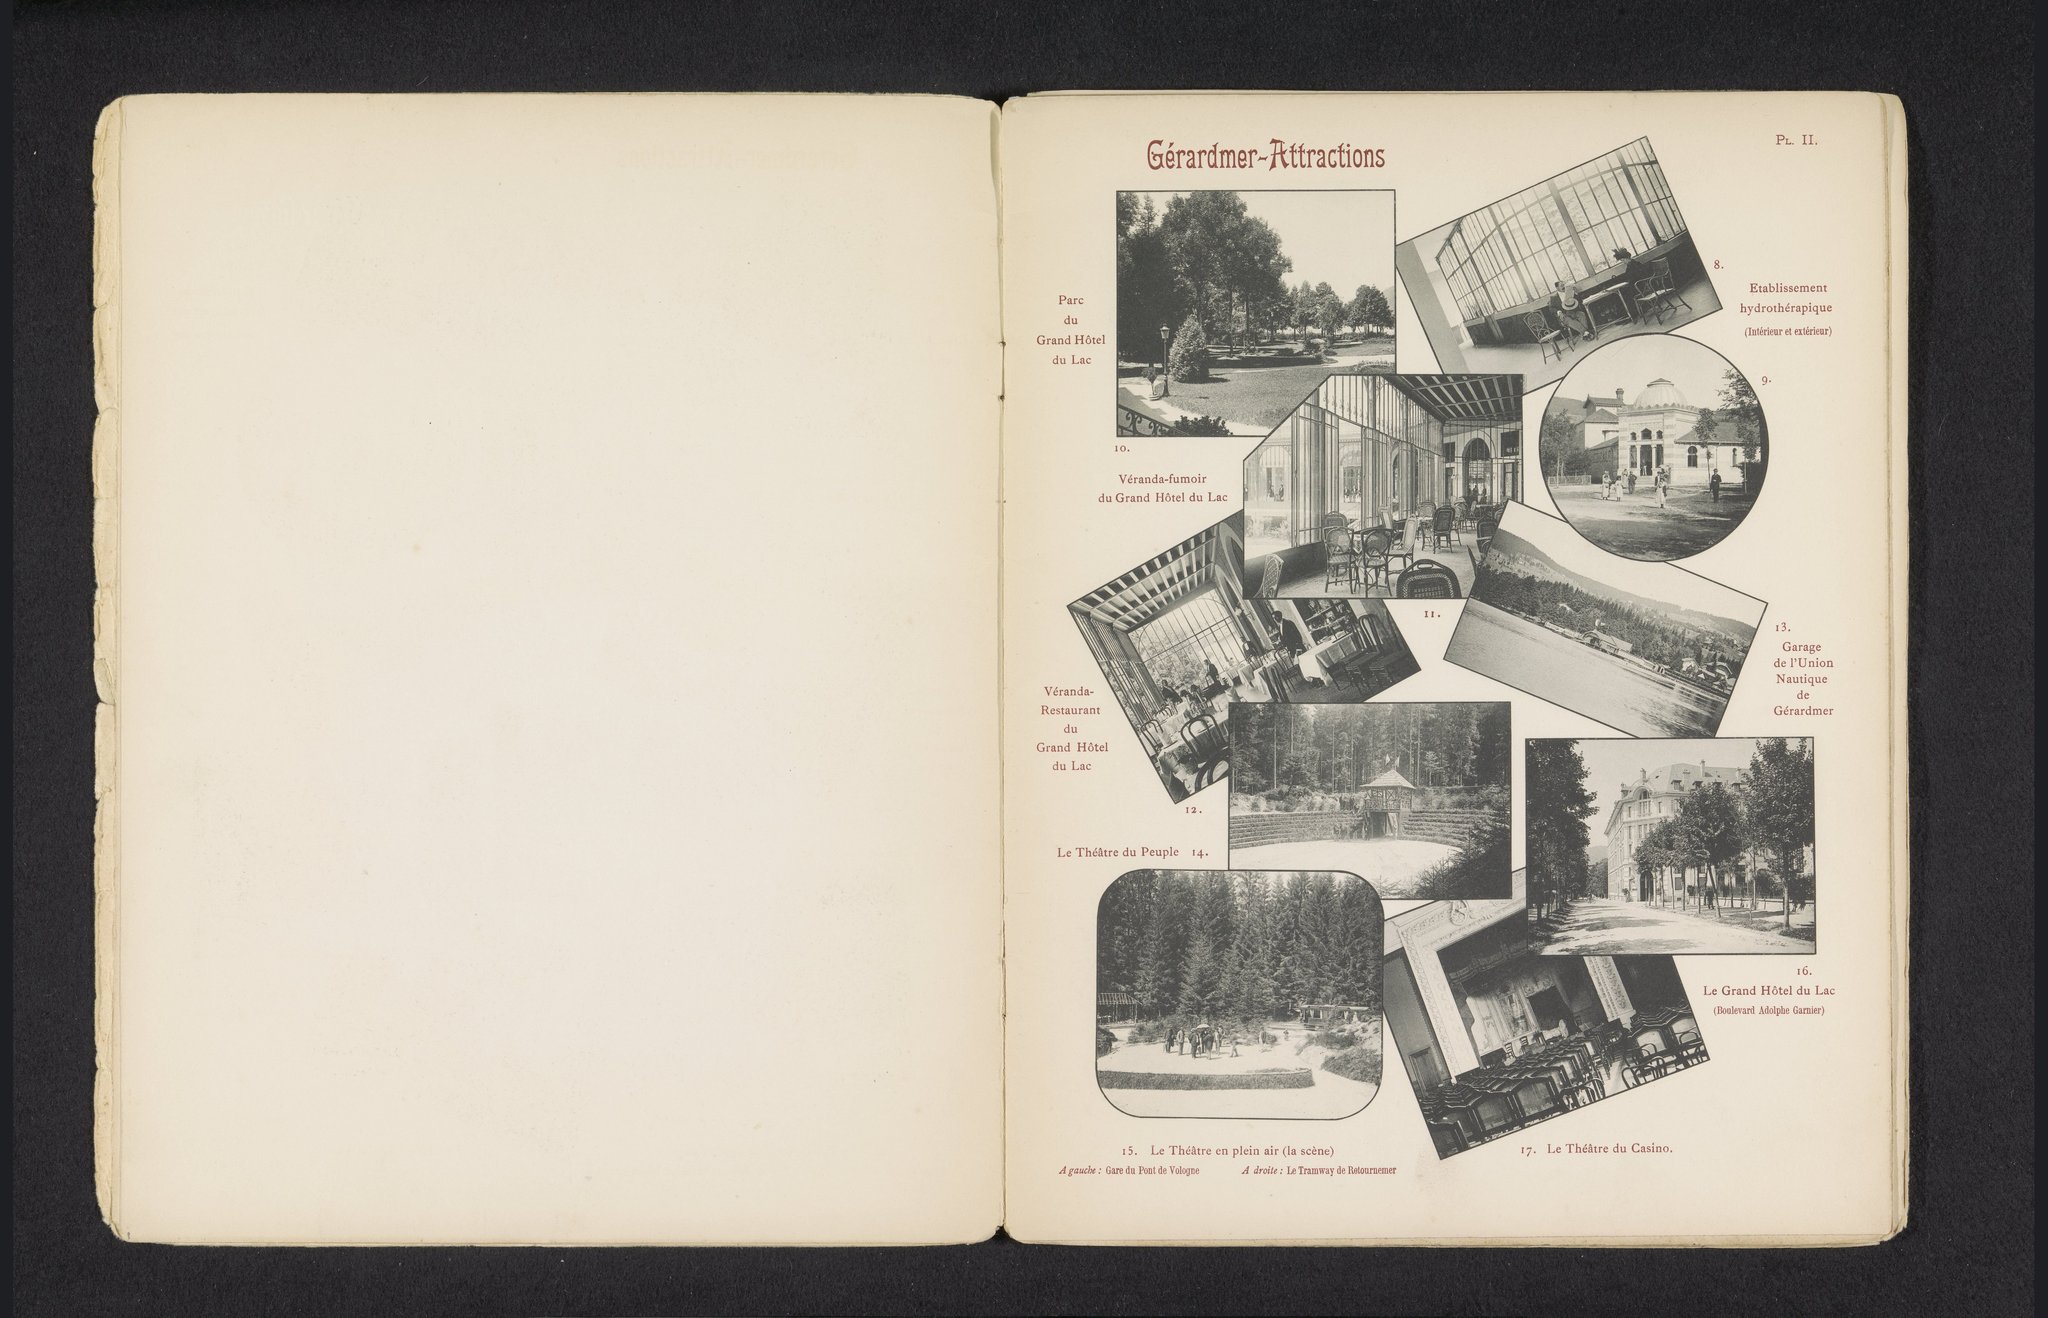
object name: photomechanical print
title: Tien bezienswaardigheden in Gérardmer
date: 1888-1898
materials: paper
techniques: photograph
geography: gérardmer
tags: avenue, boulevard in village, casino, hotel, hostelry, inn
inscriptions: number: ‘Pl. II.’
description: Nummers 8 tot en met 17: Interieur van het instituut voor hydrotherapie, exterieur van het instituut voor hydrotherapie, park van het Grand Hôtel du Lac, veranda van het Grand Hôtel du lac, restaurant van Grand Hôtel du Lac, garage voor boten, een amfitheater, het exterieur van het Grand Hôtel du Lac en het theater van het casino.